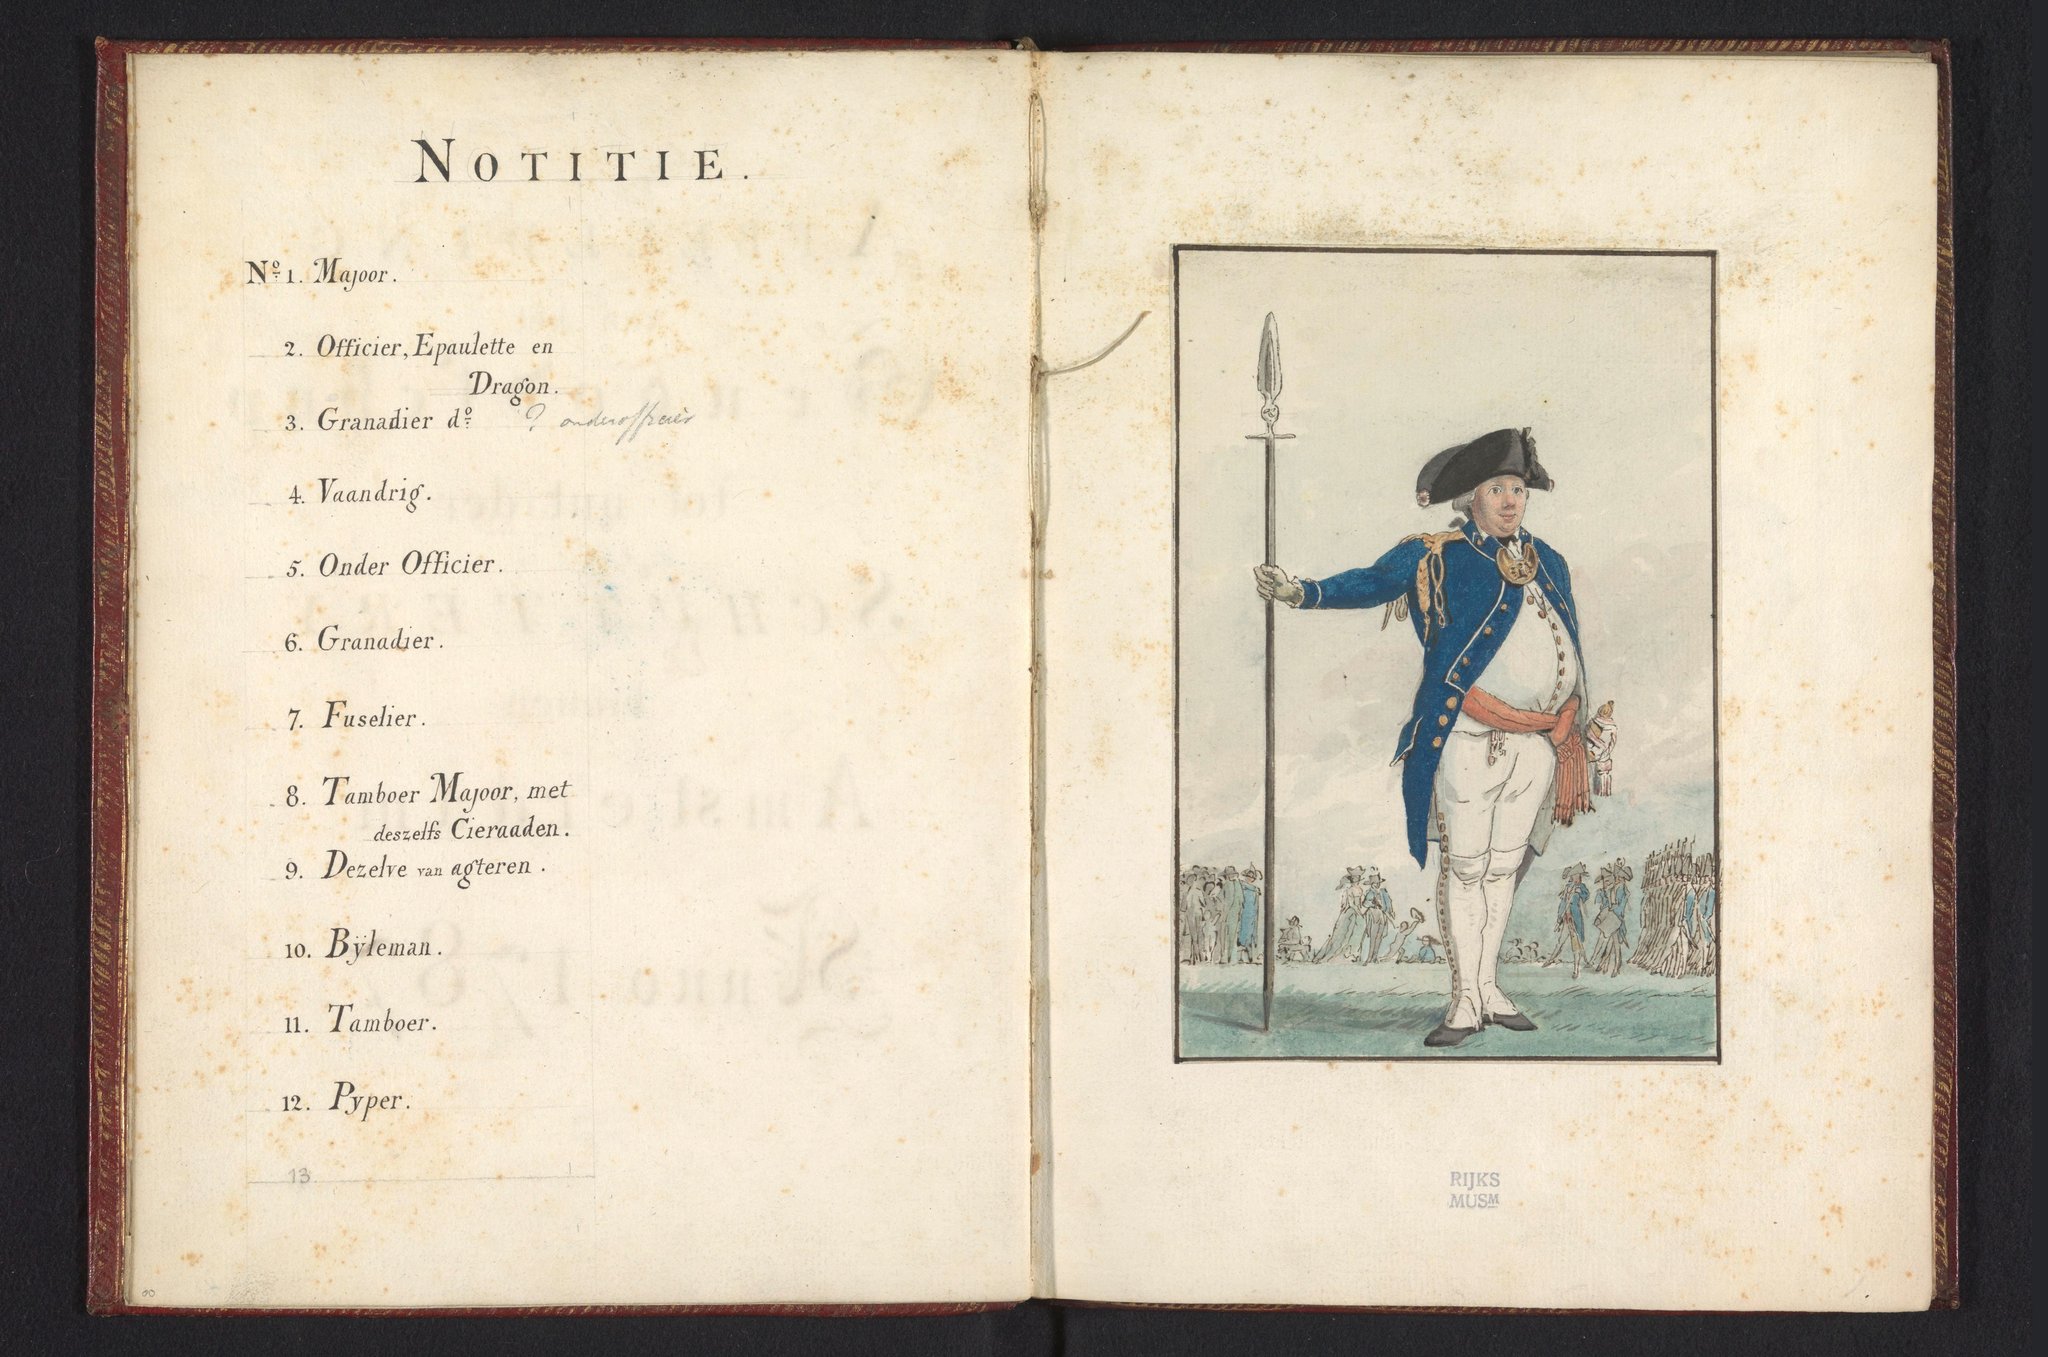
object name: titelblad, titelpagina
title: Inhoudsopgave van het album van de uniformen van het Genootschap tot Nut der Schutterij te Amsterdam in 1787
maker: Anonymous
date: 1787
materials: paper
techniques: writing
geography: amsterdam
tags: amsterdam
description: Handgeschreven inhoudsopgave van het album met veertien ingeplakte gekleurde tekeningen van de uniformen van schutters van het patriotse Genootschap tot Nut der Schutterij te Amsterdam in het jaar 1787.